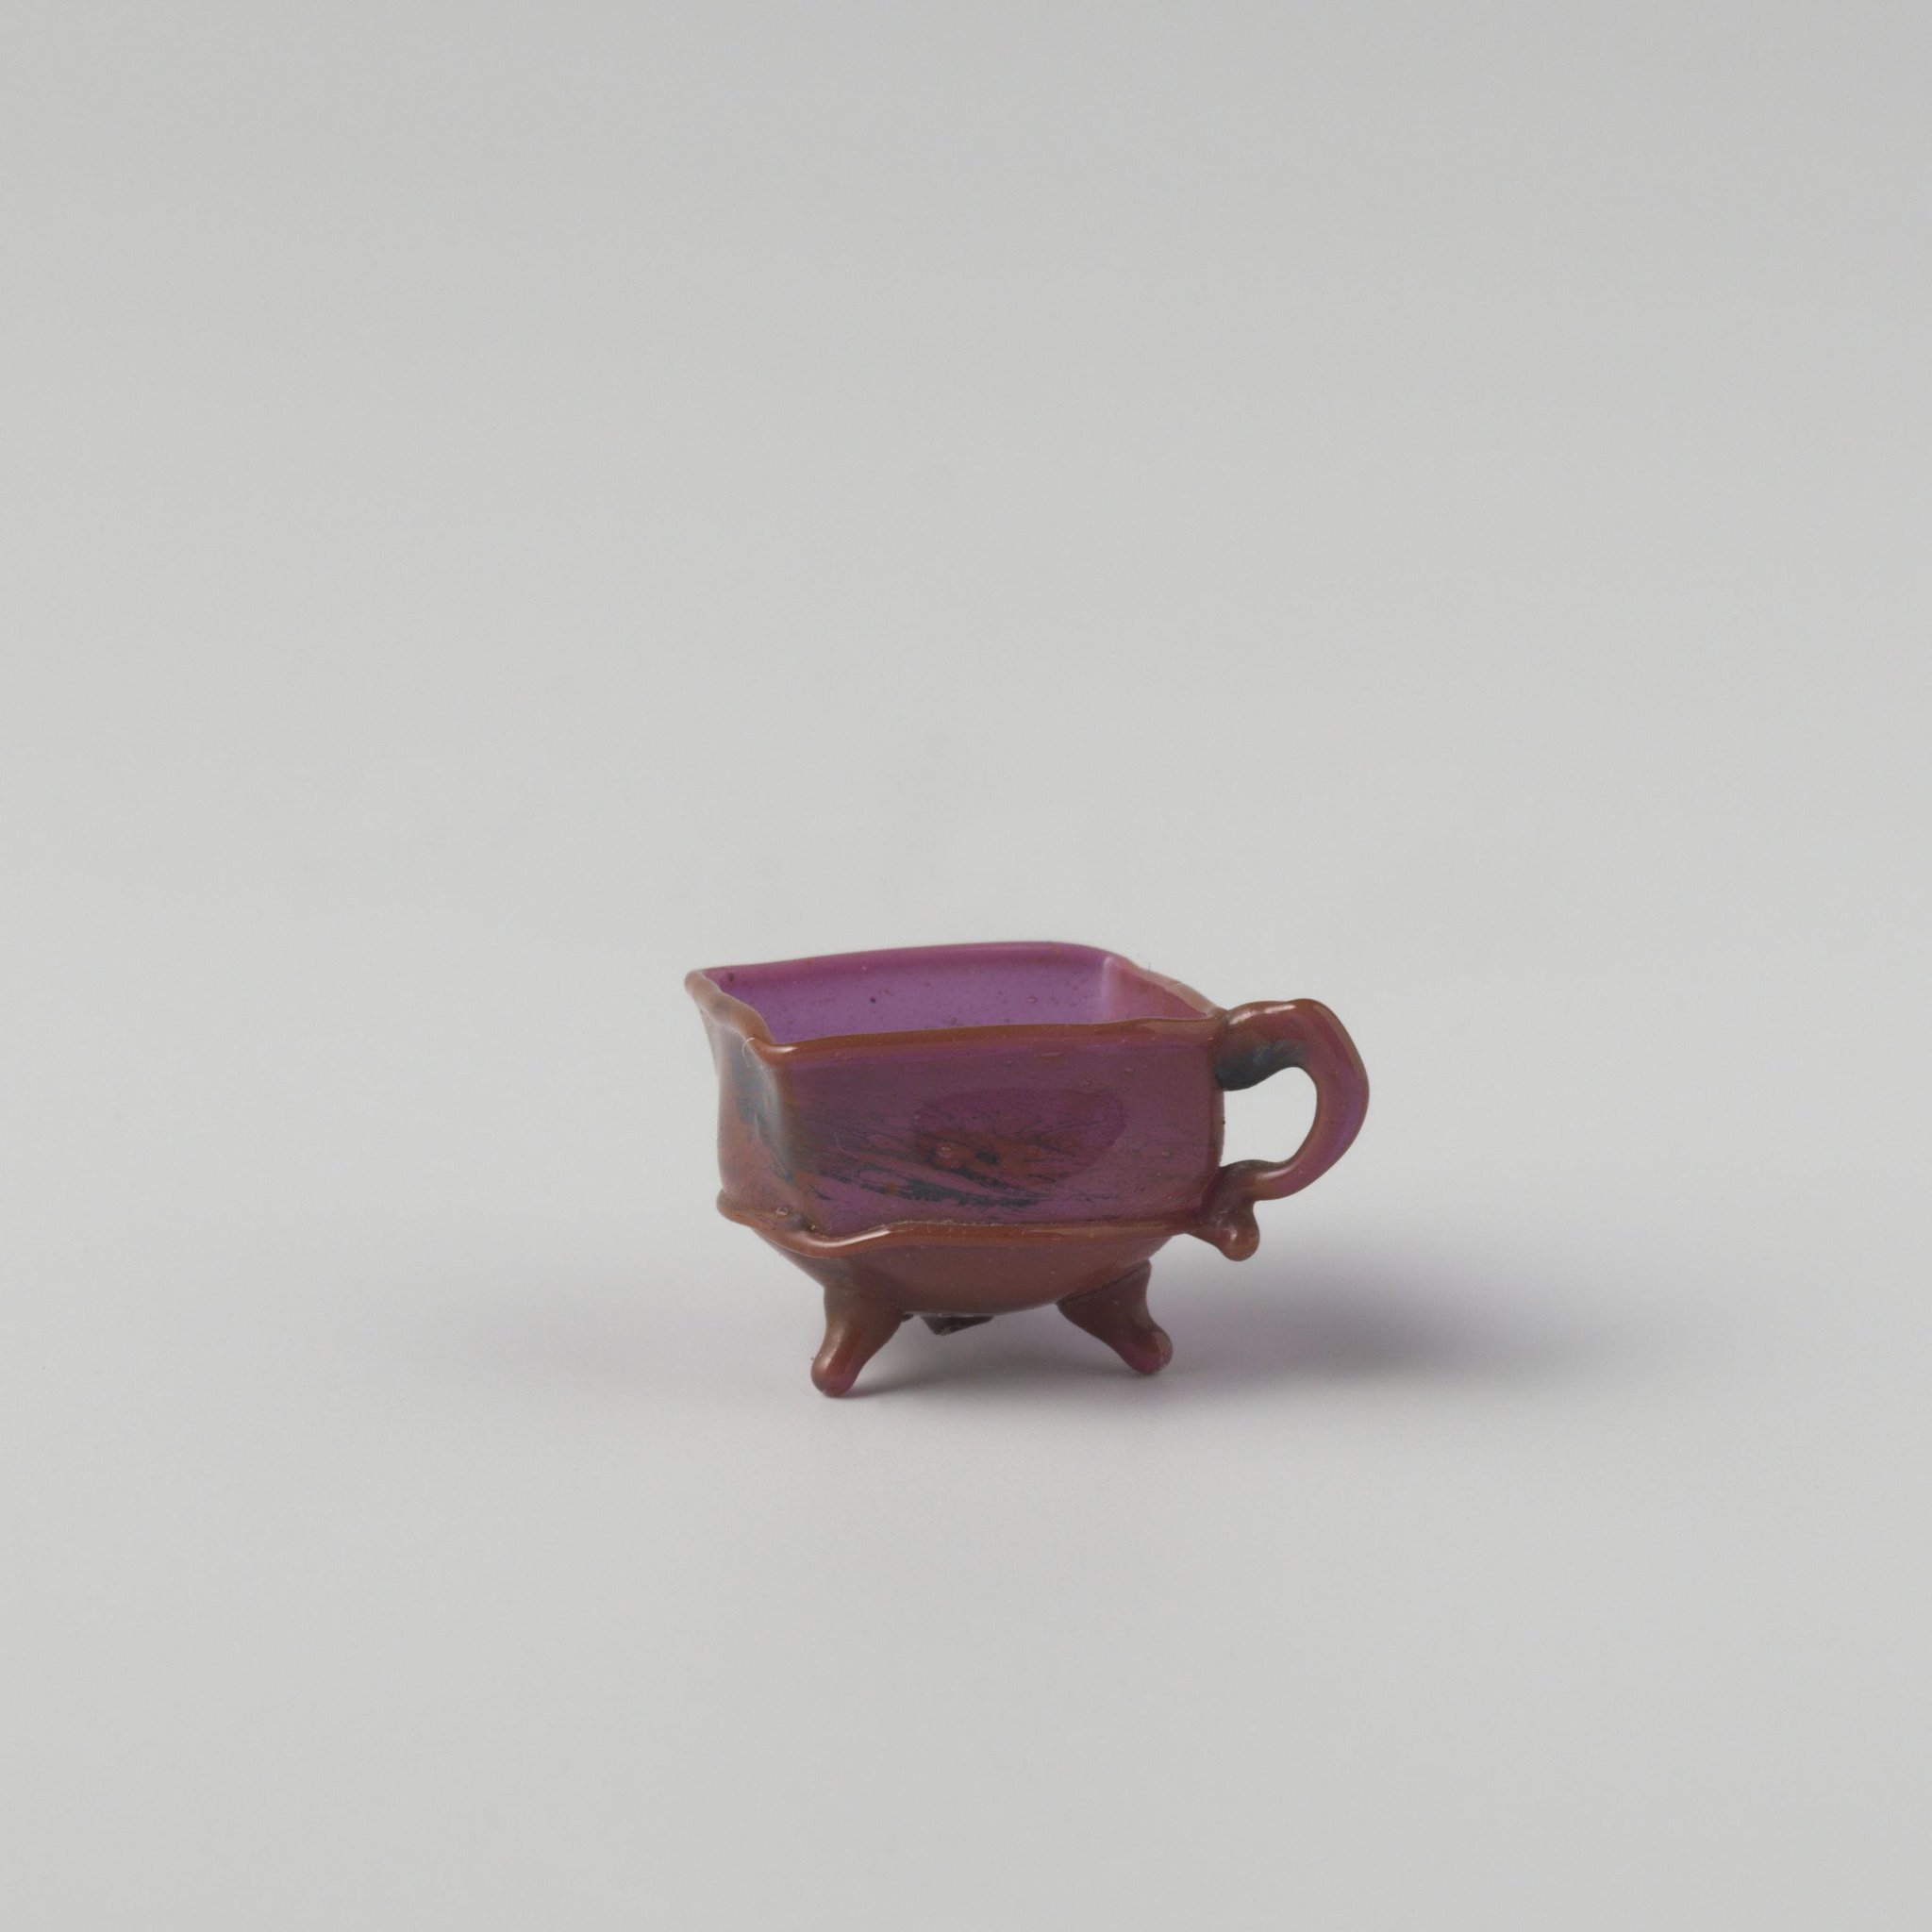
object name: miniature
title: Vierkante vuurtest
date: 1675-1700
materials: glass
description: Vierkante vuurtest op drie poten, vervaardigd van opaak, bruinpaars glas.